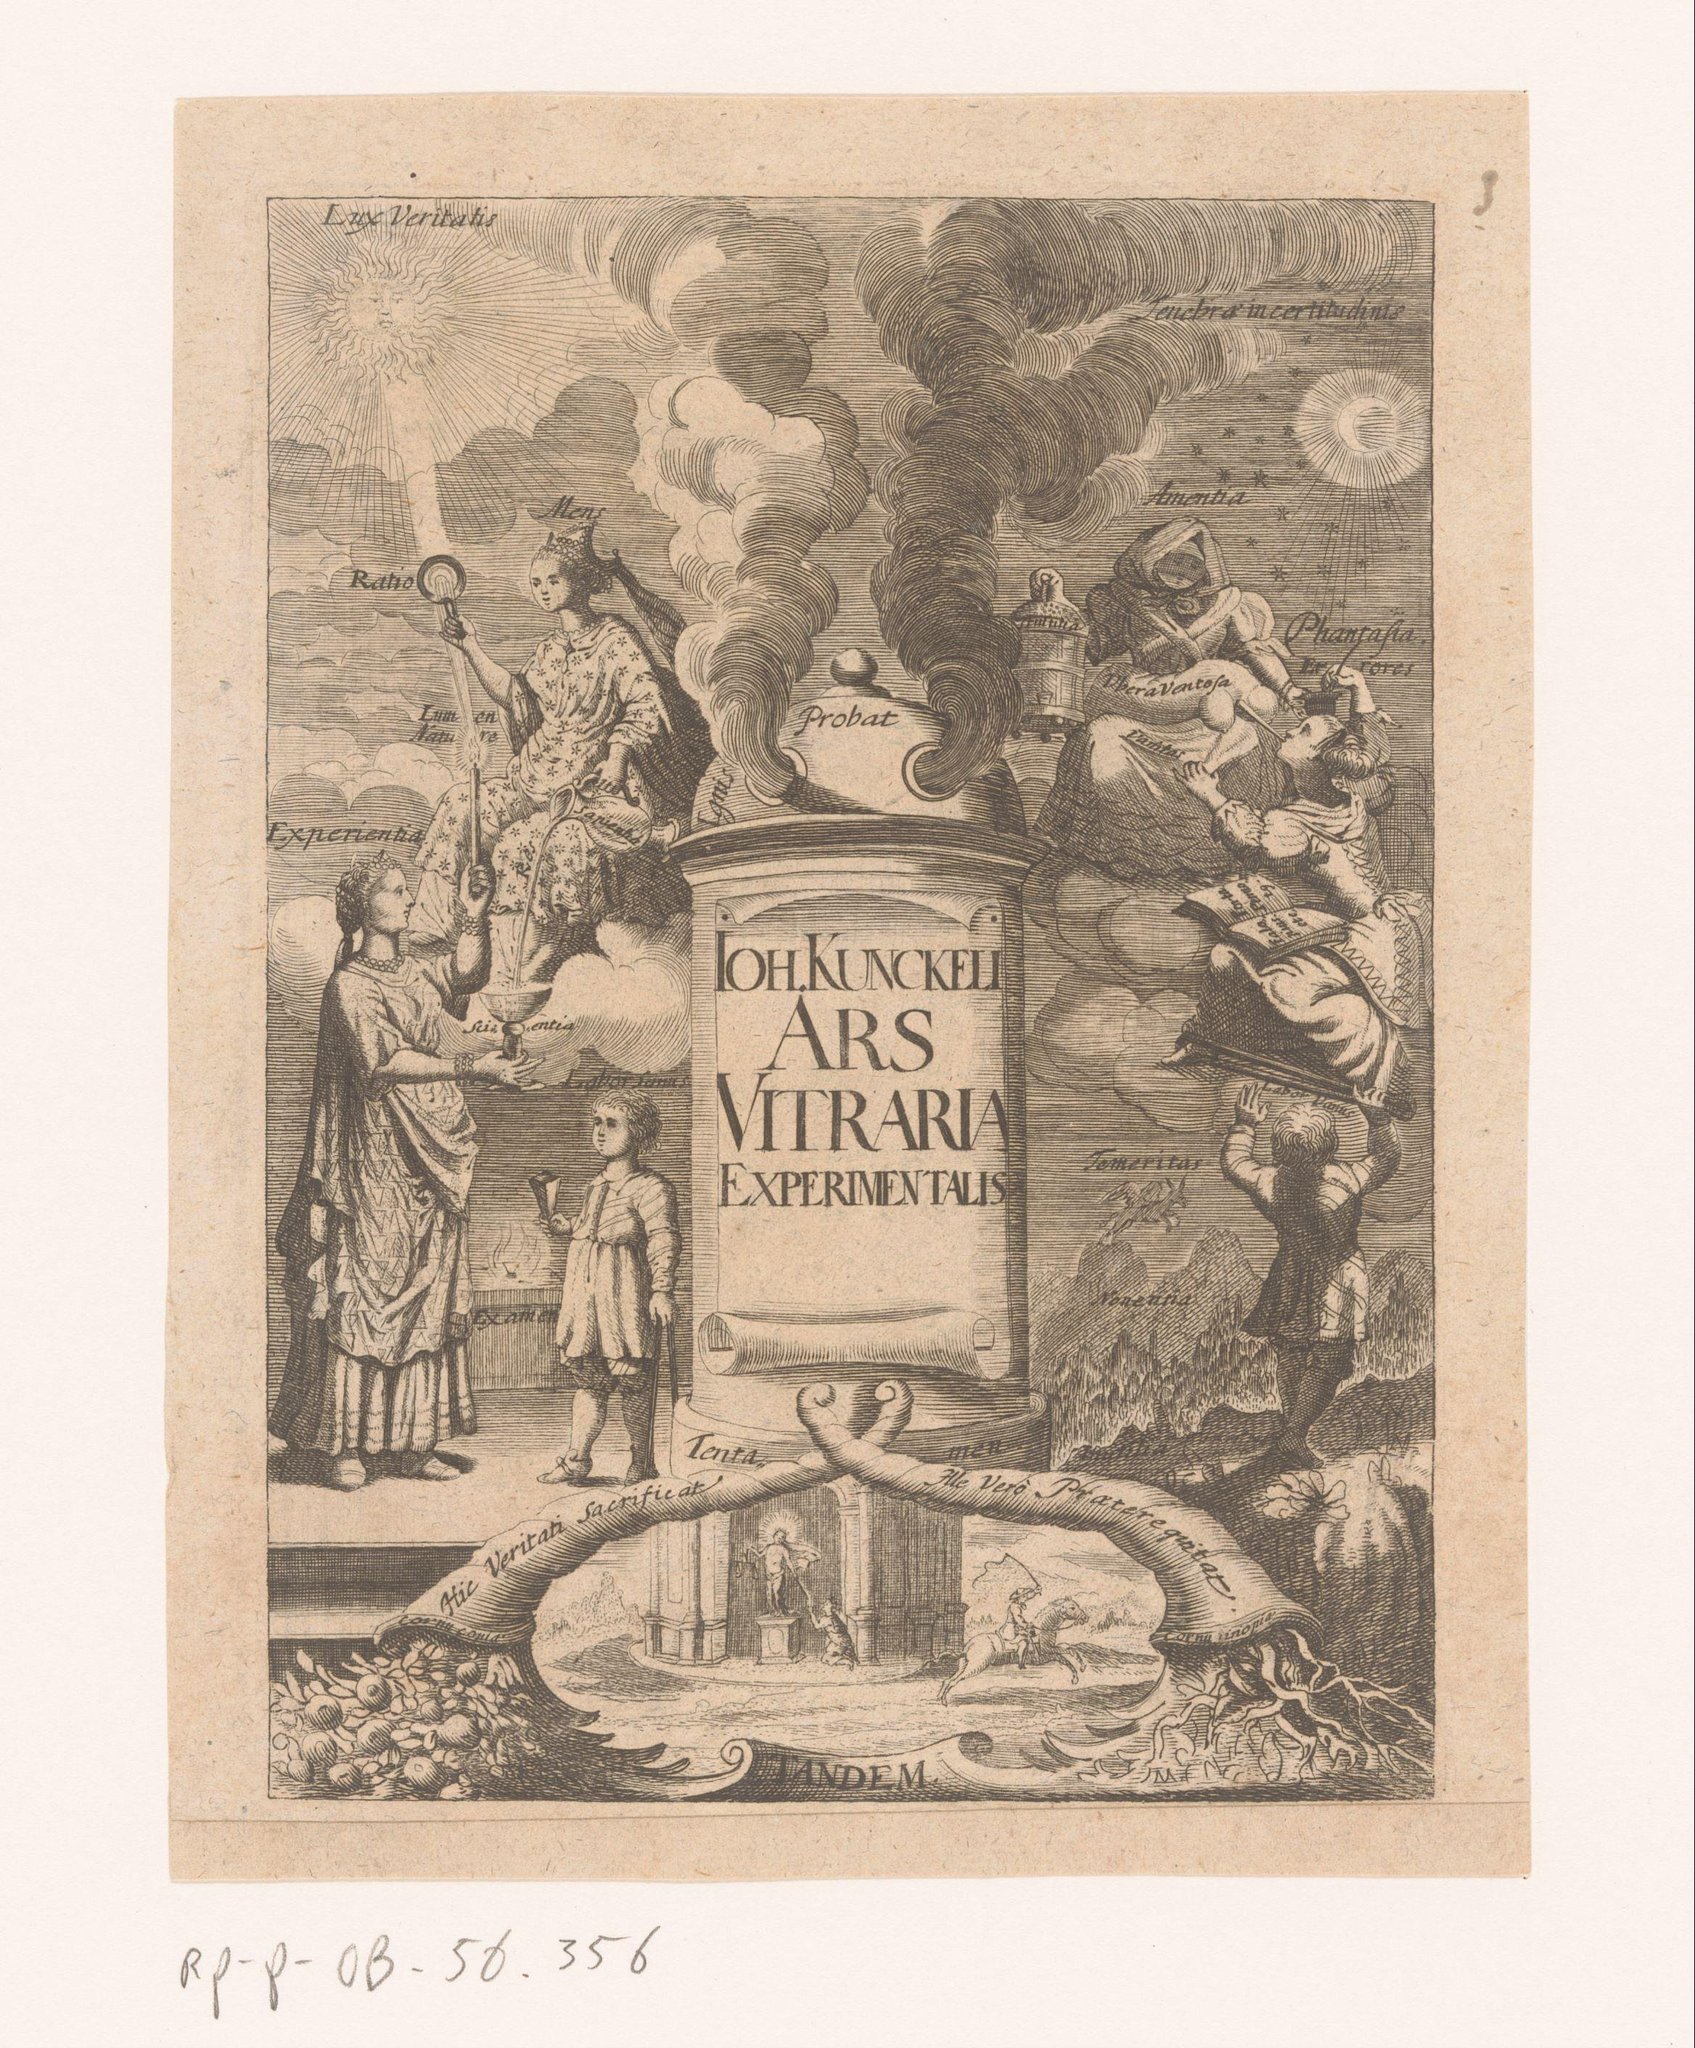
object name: titelprent, frontispice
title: Titelprent voor: Johannes Kunckel von Löwenstjern, Ars vitraria experimentalis oder Vollkommene Glasmacher-Kunst, 1679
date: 1679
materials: paper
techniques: etching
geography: germany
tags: glass-maker, other handicrafts ~ glass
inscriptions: collector's mark: Lugt 2228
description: Titelpagina voor: Kunckel von Löwenstjern, Johannes. Ars vitraria experimentalis oder Vollkommene Glasmacher-Kunst. Frankfurt am Main: Johannes Kunckel von Löwenstjern, 1679.